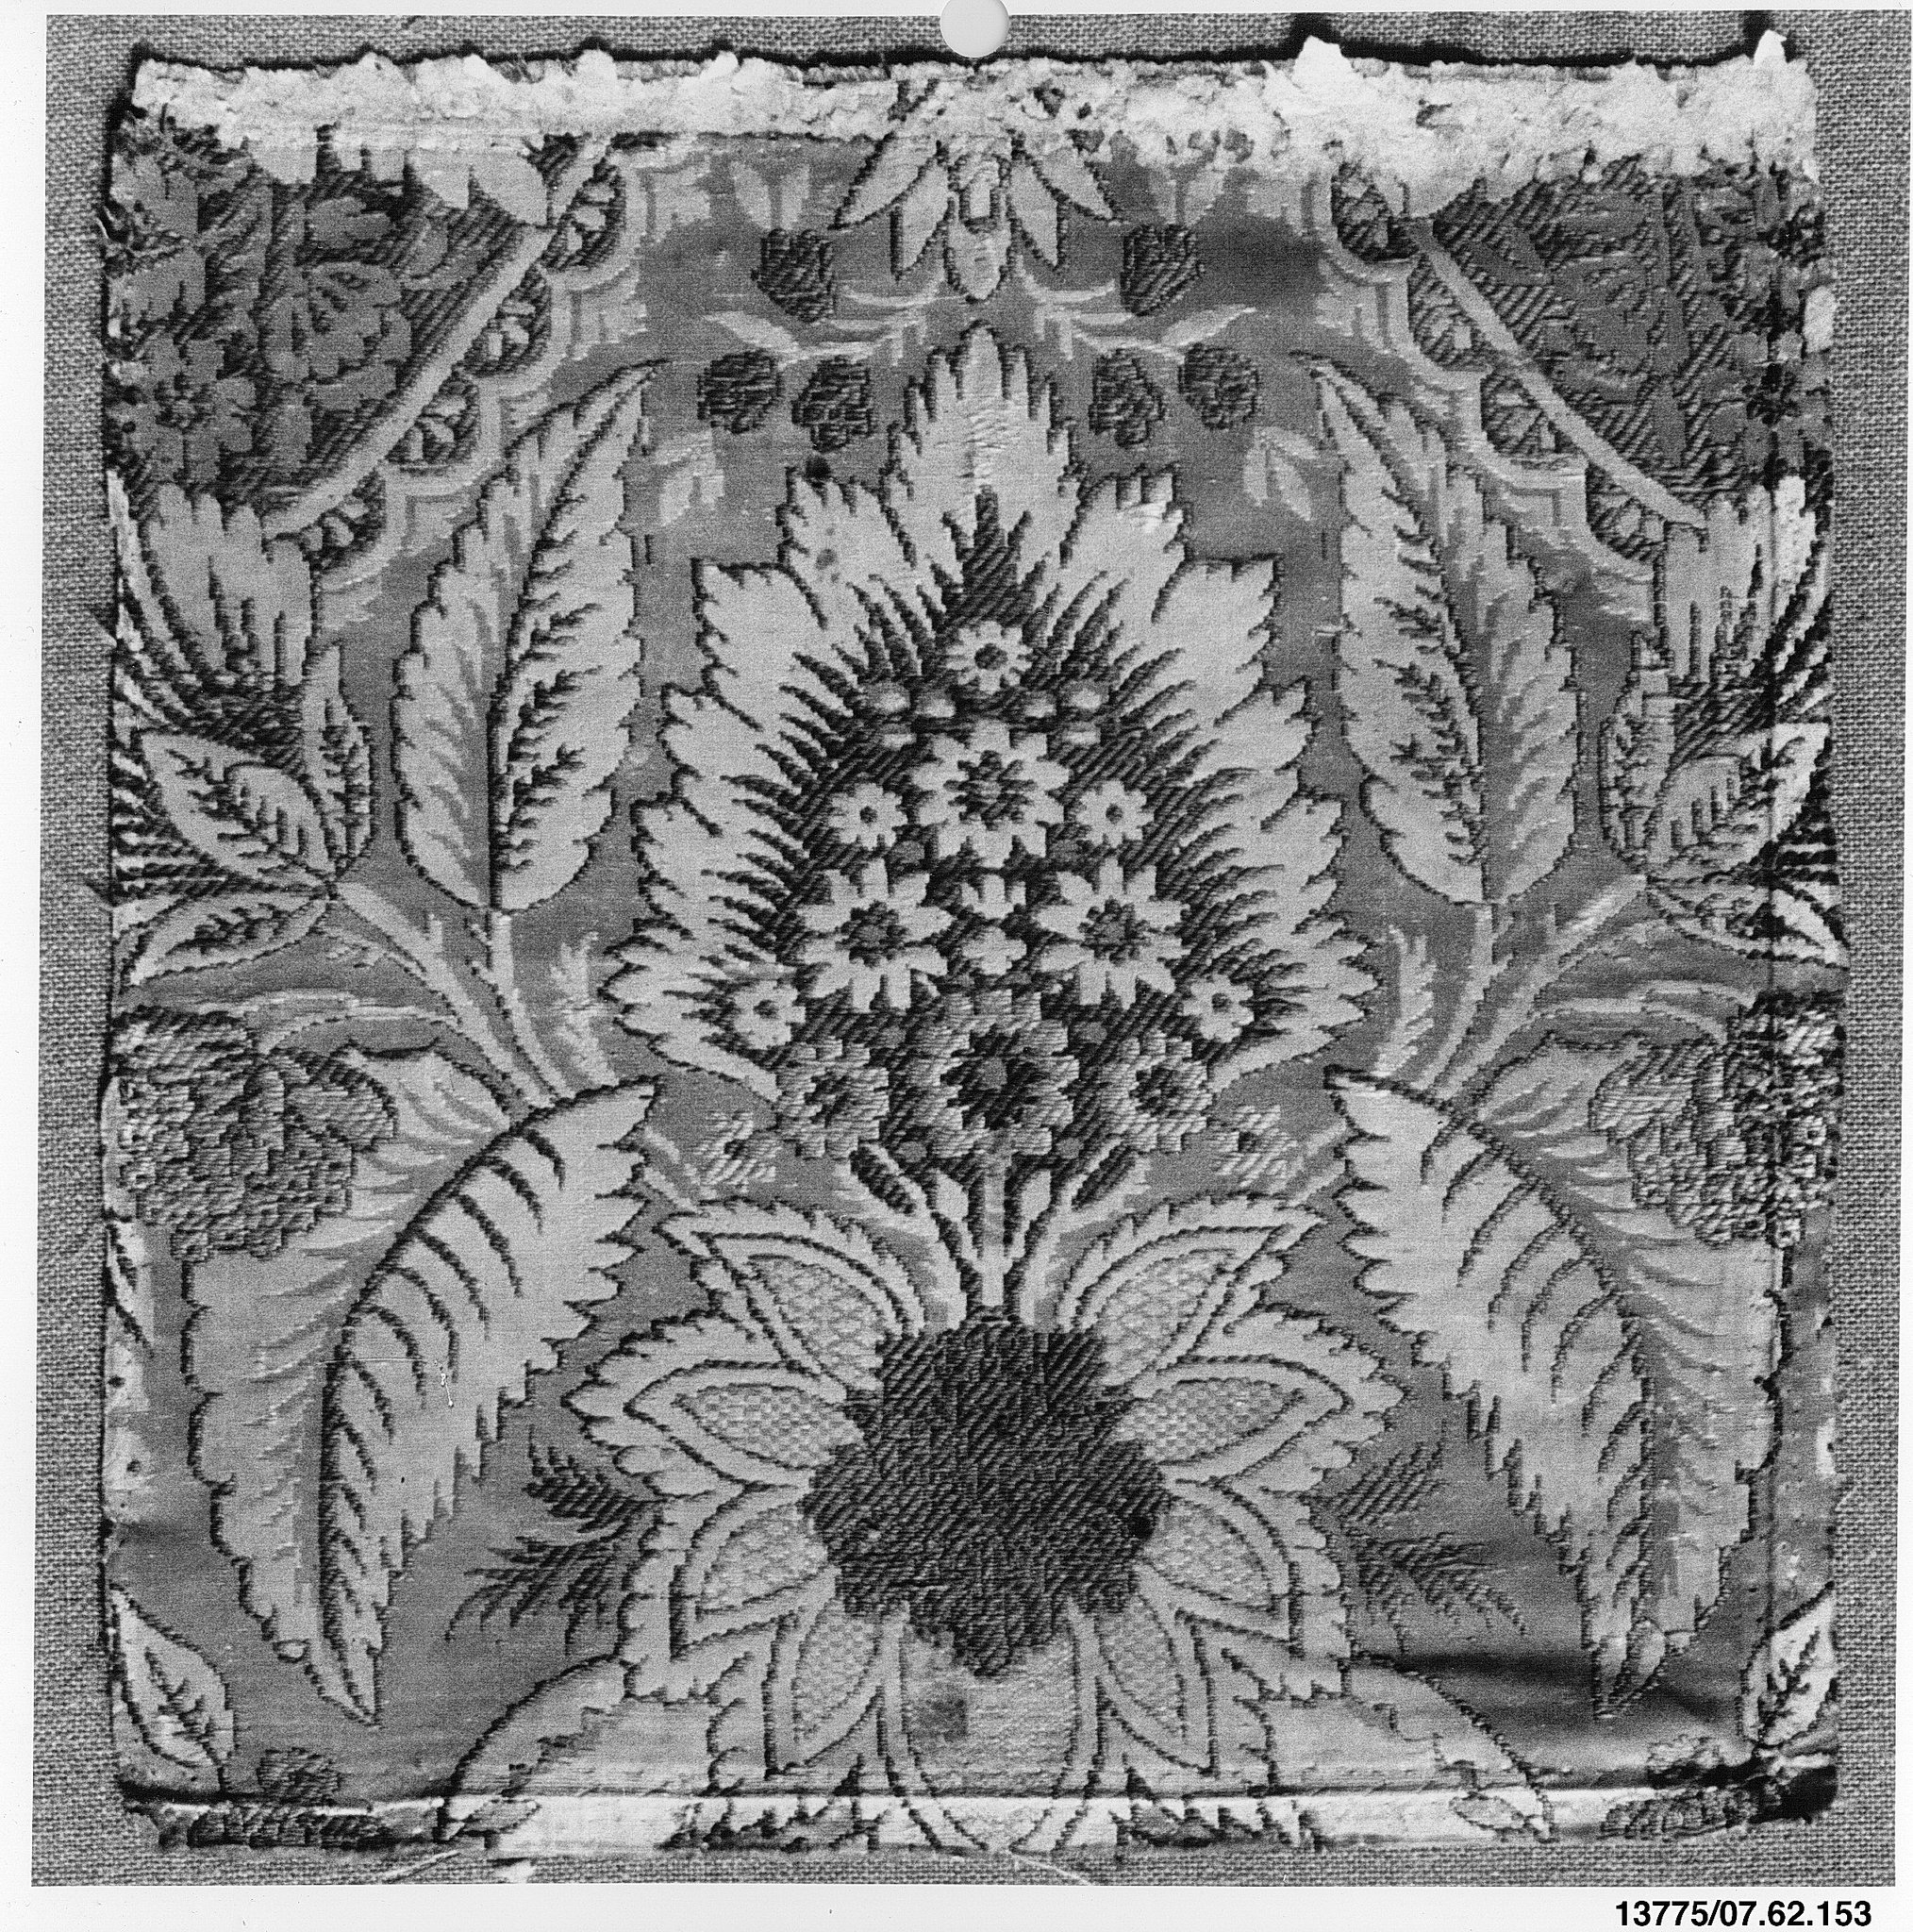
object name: piece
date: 1720-1730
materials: silk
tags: flowers,leaves